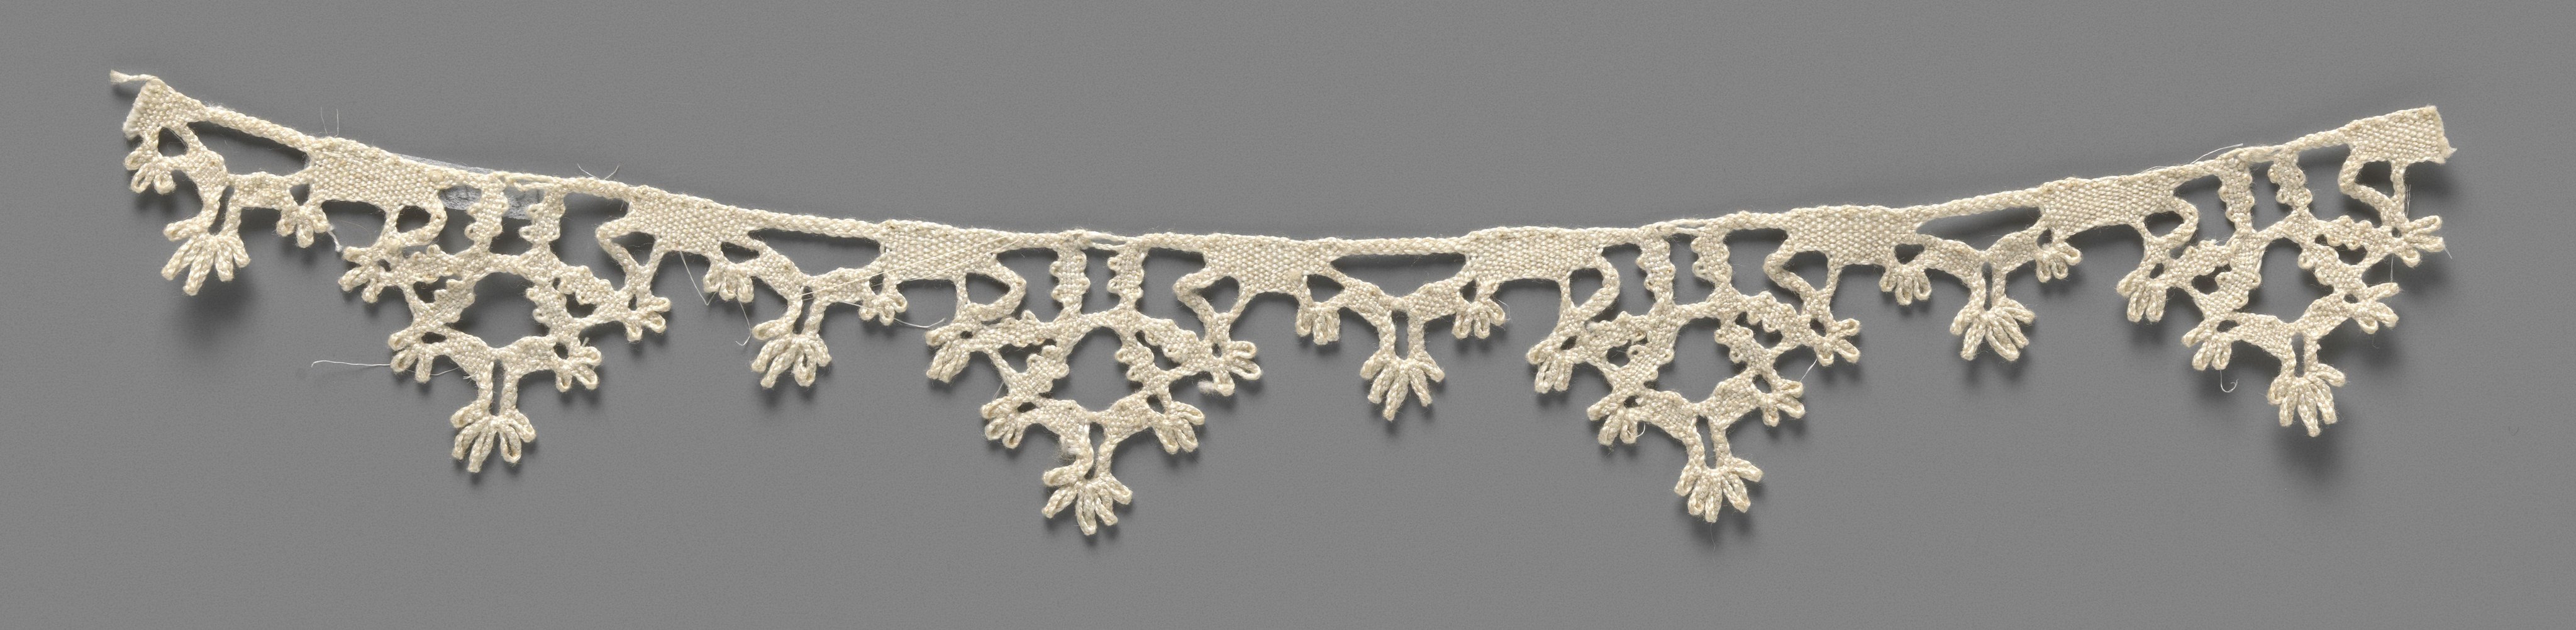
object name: strip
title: Strook kloskant met driehoekige schulpen met lusjes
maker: Anonymous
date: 1925-1937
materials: linen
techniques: lace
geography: pescocostanzo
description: Strook naturelkleurige kloskant. Het zich herhalende en symmetrische patroon bestaat uit afwisselend grote en kleinere driehoekige schulpen aan een vlecht die de bovenrand van de strook vormt. De schulpen zijn opgebouwd uit min of meer rechthoekige blokjes gemaakt in linnenslag die met korte 'vlechtjes' van dubbele netslag met elkaar verbonden zijn. Onderaan elke schulp en langs de randen van de schulpen zijn bundeldjes lusjes gemaakt met vlechtjes. Het betreft 20e-eeuws kant gemaakt naar een 16e-eeuws patroon.